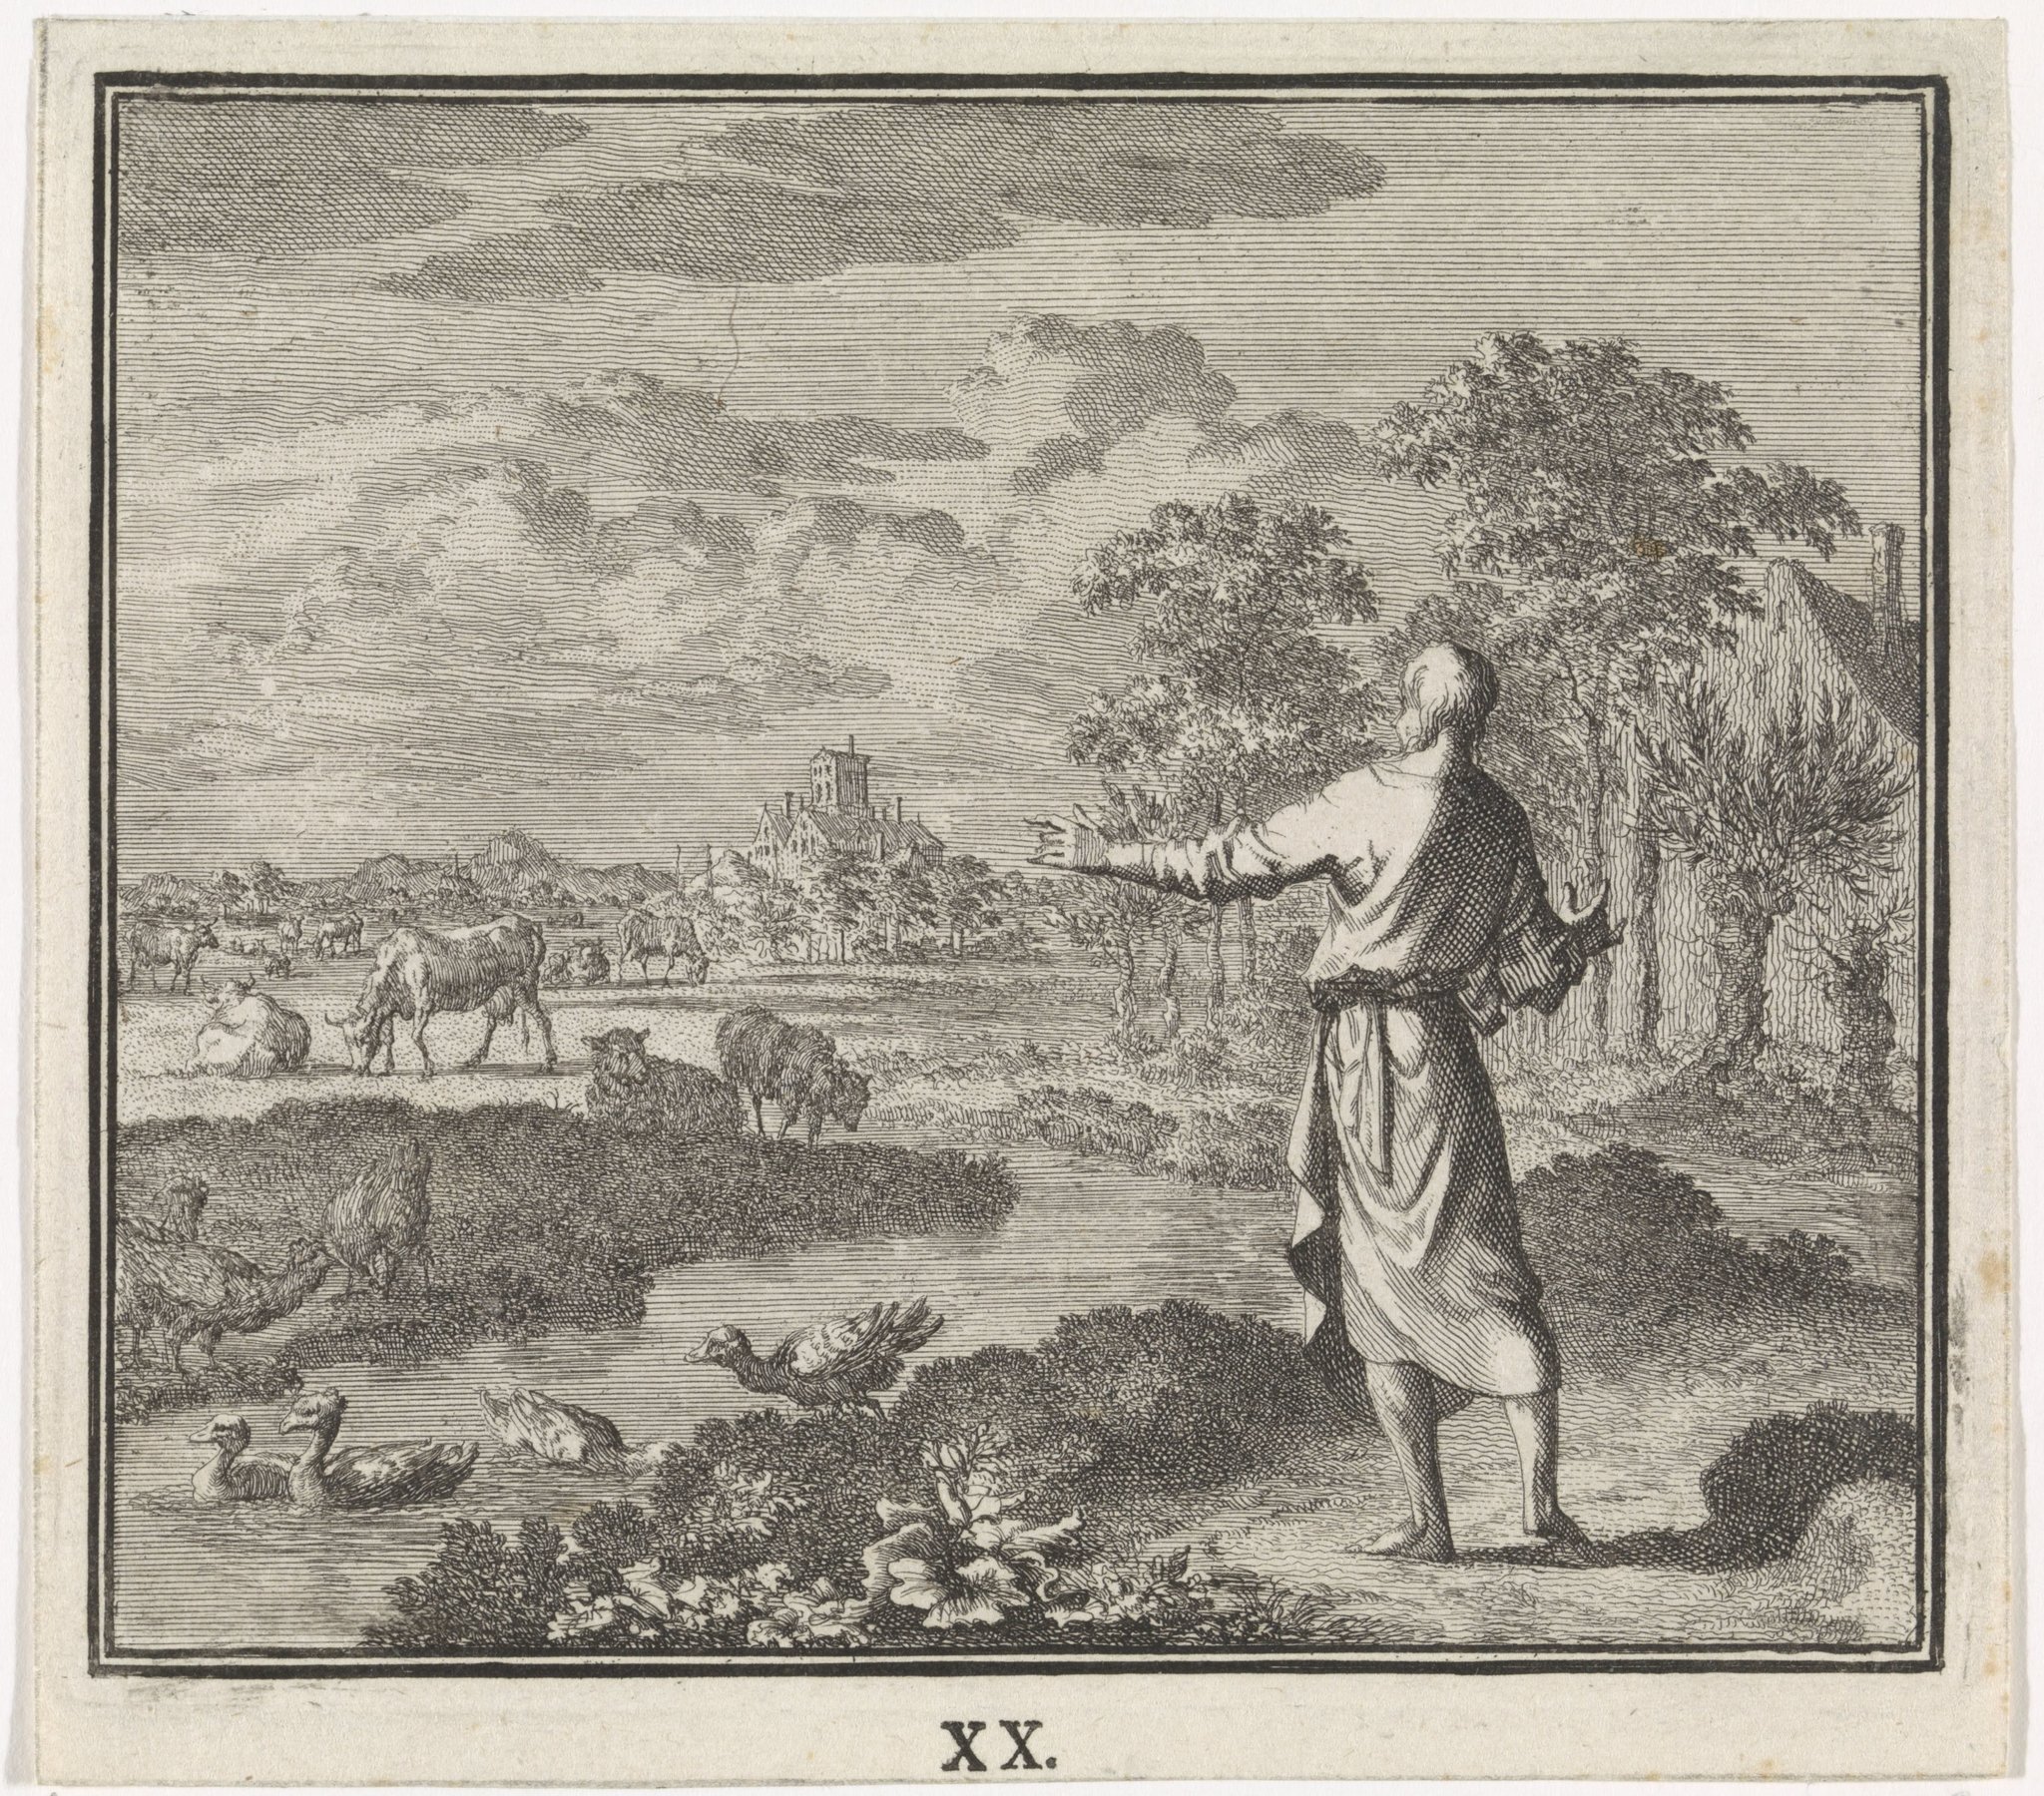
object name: book illustration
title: Embleem: weiland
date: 1695-1705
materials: paper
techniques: etching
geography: nuremberg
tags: cow, meadow, pasture, 'en route', traveller under way, water-birds: duck, abstract ideas and concepts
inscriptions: collector's mark: Lugt 2228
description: Boekillustratie voor Weigel, Christoph. Ethica Naturalis seu Documenta Moralia e Variis rerum Naturalium proprietatibus Virtutum Vitiorumq symbolicis imaginibus collecta. Neurenberg: Christoph Weigel: c. 1700.